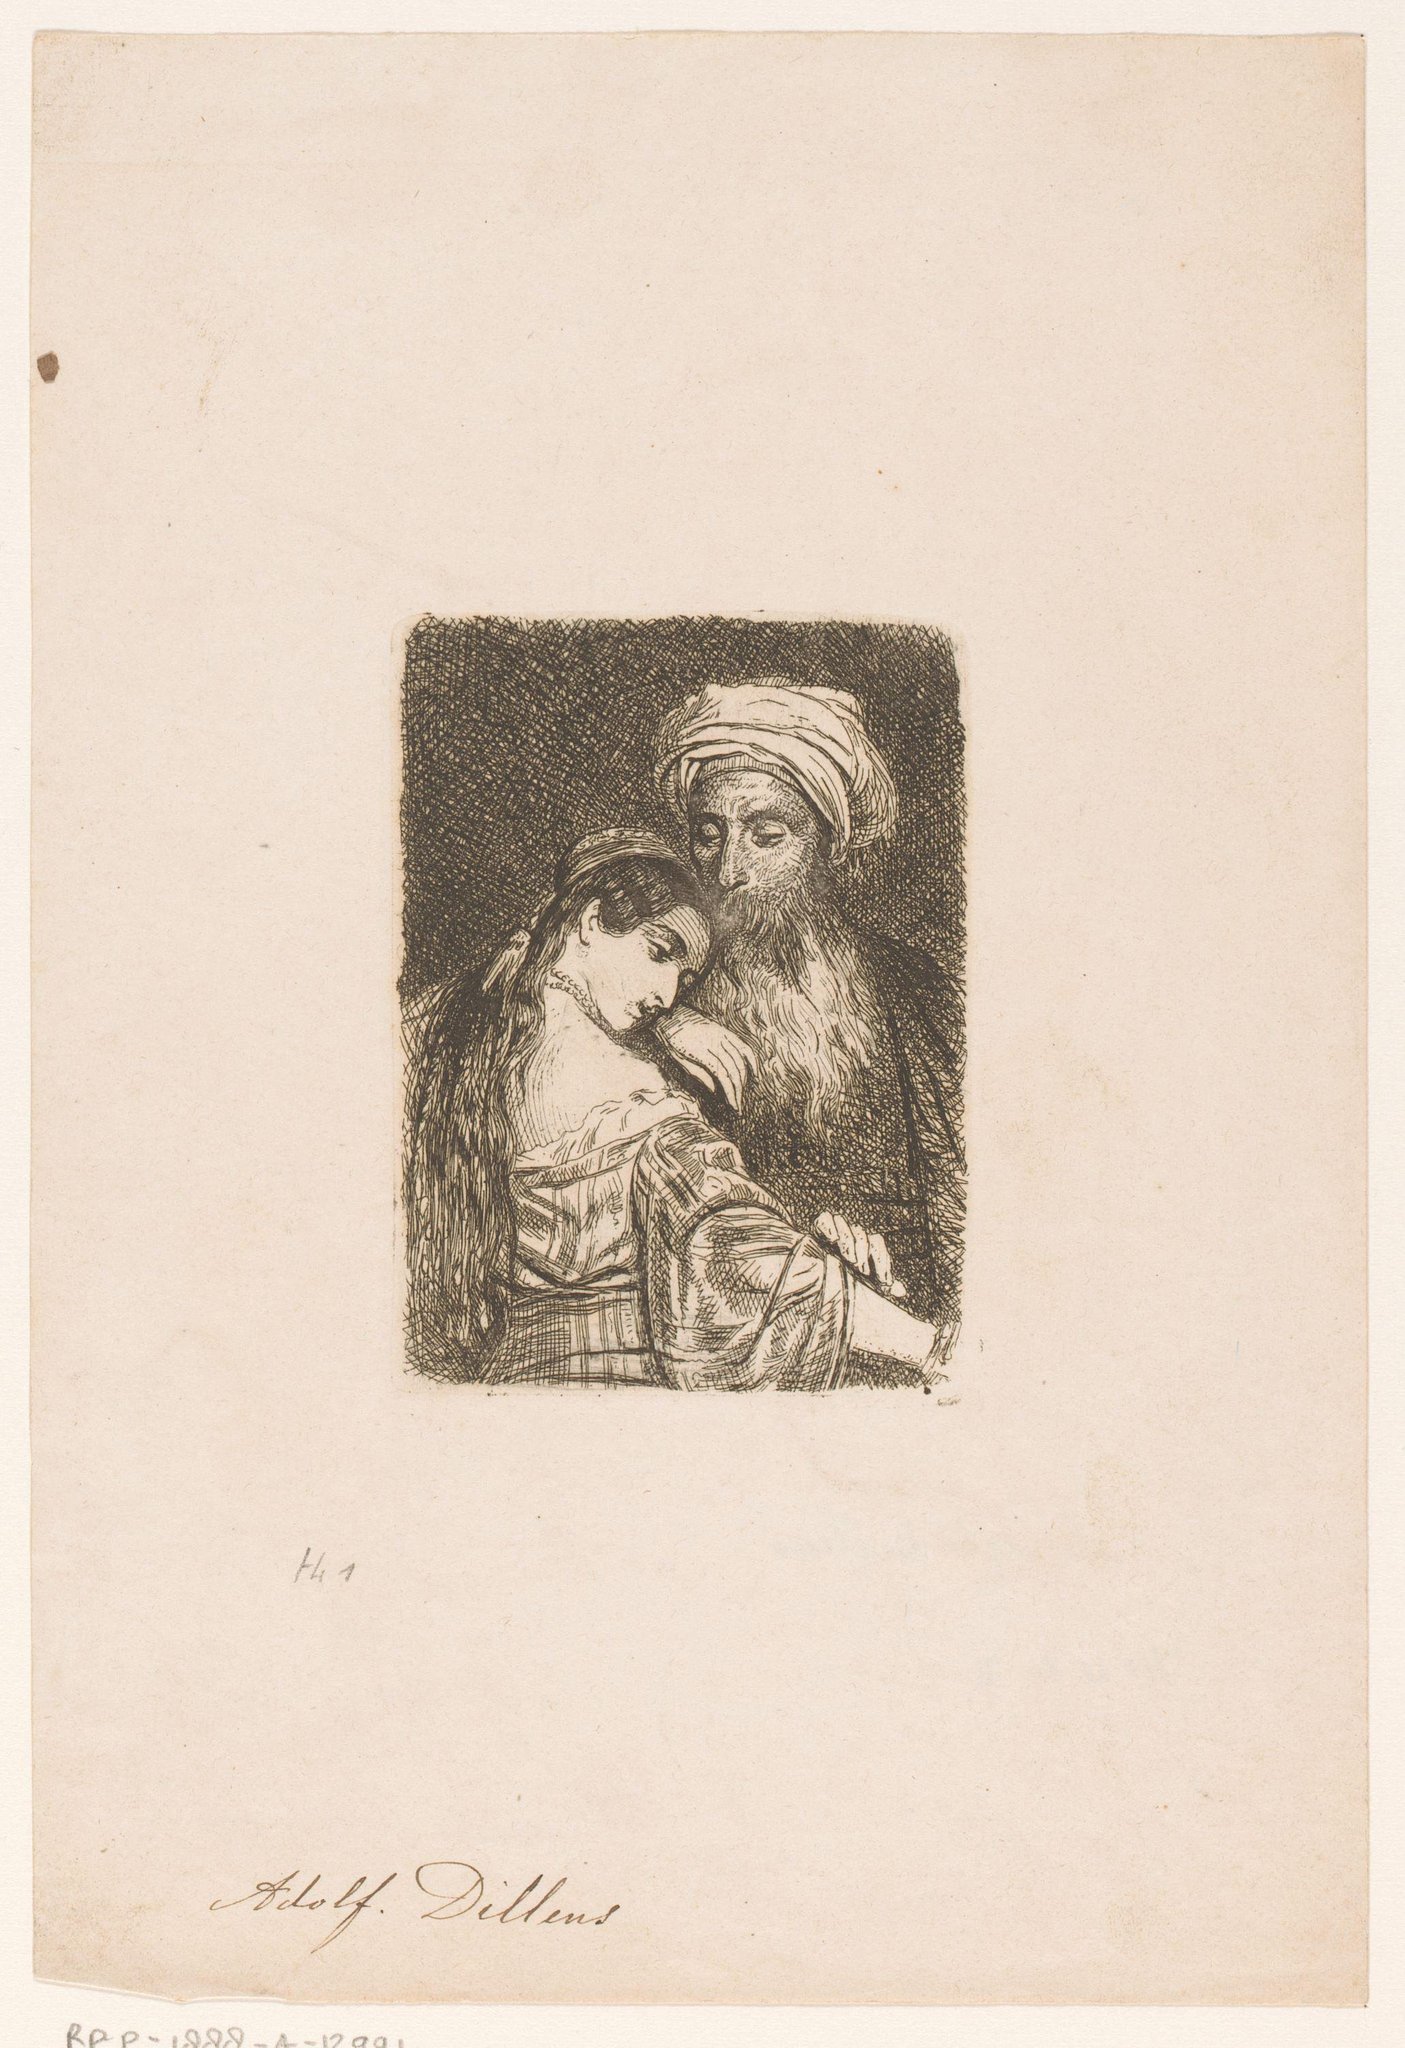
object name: print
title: Vrouw leunend op de schouder van een man met tulband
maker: adolphe alexandre dillens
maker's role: draughtsman, painter, print maker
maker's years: 1821-1877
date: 1831-1877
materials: paper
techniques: etching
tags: adolescent, young woman, maiden, head-gear, adult man, bracelet, wristlet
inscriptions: collector's mark: Lugt 2228